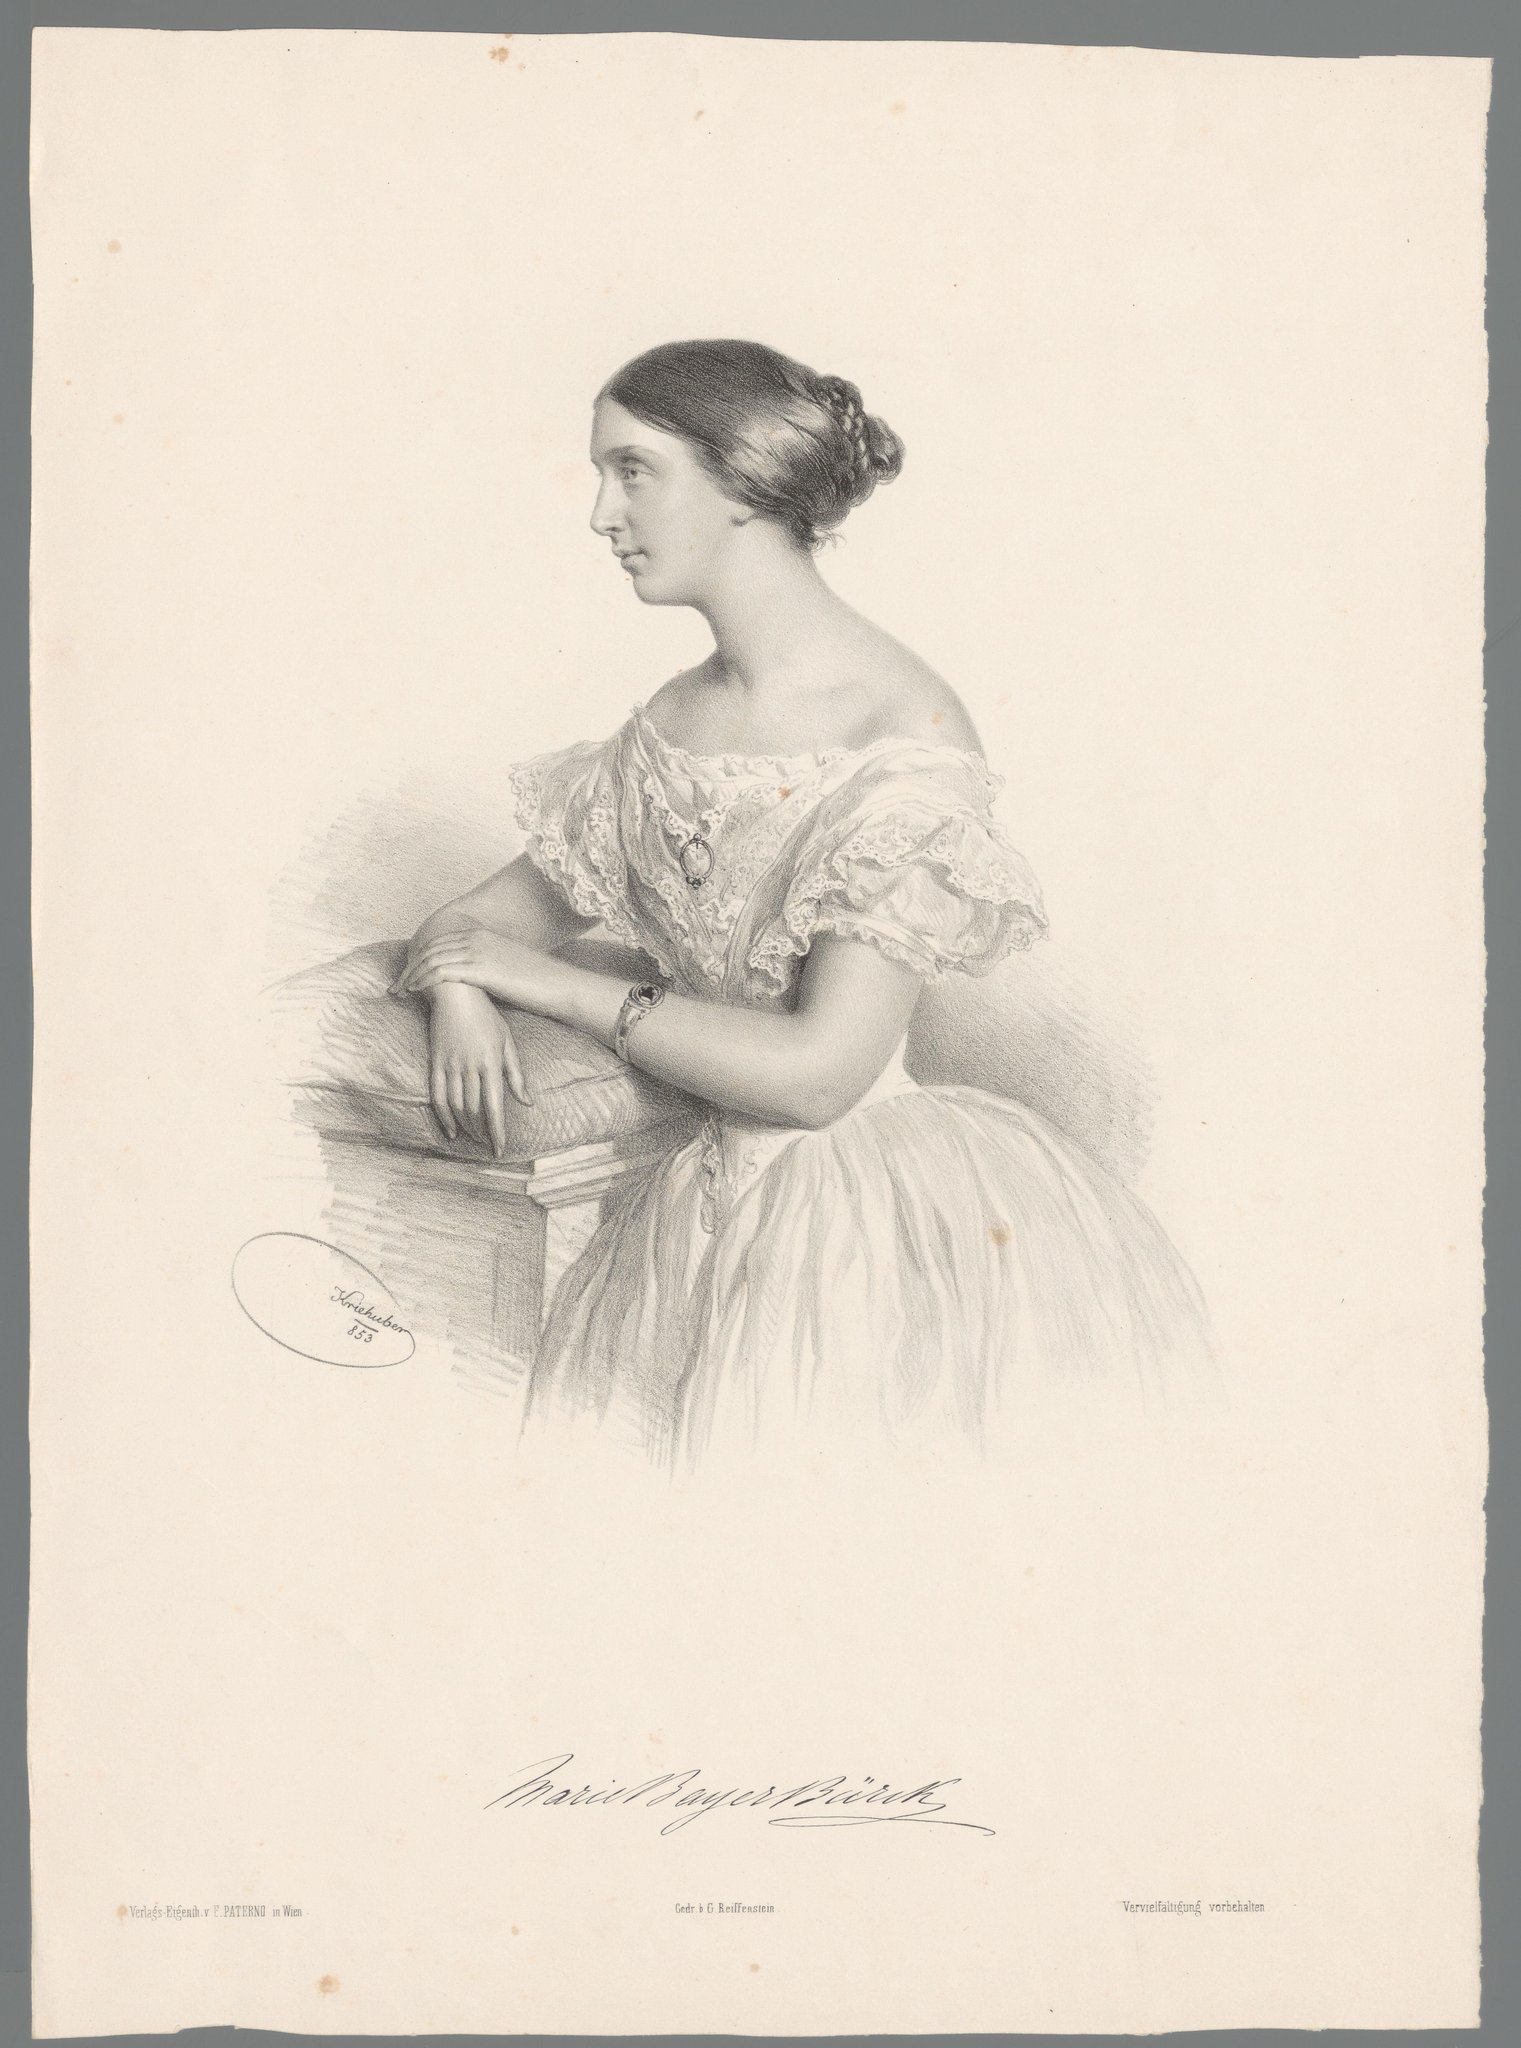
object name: print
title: Portret van Marie Bayer-Bürck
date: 1853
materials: paper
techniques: lithograph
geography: vienna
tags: prague, historical persons, portrait of actor, actress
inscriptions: collector's mark: Lugt 2228